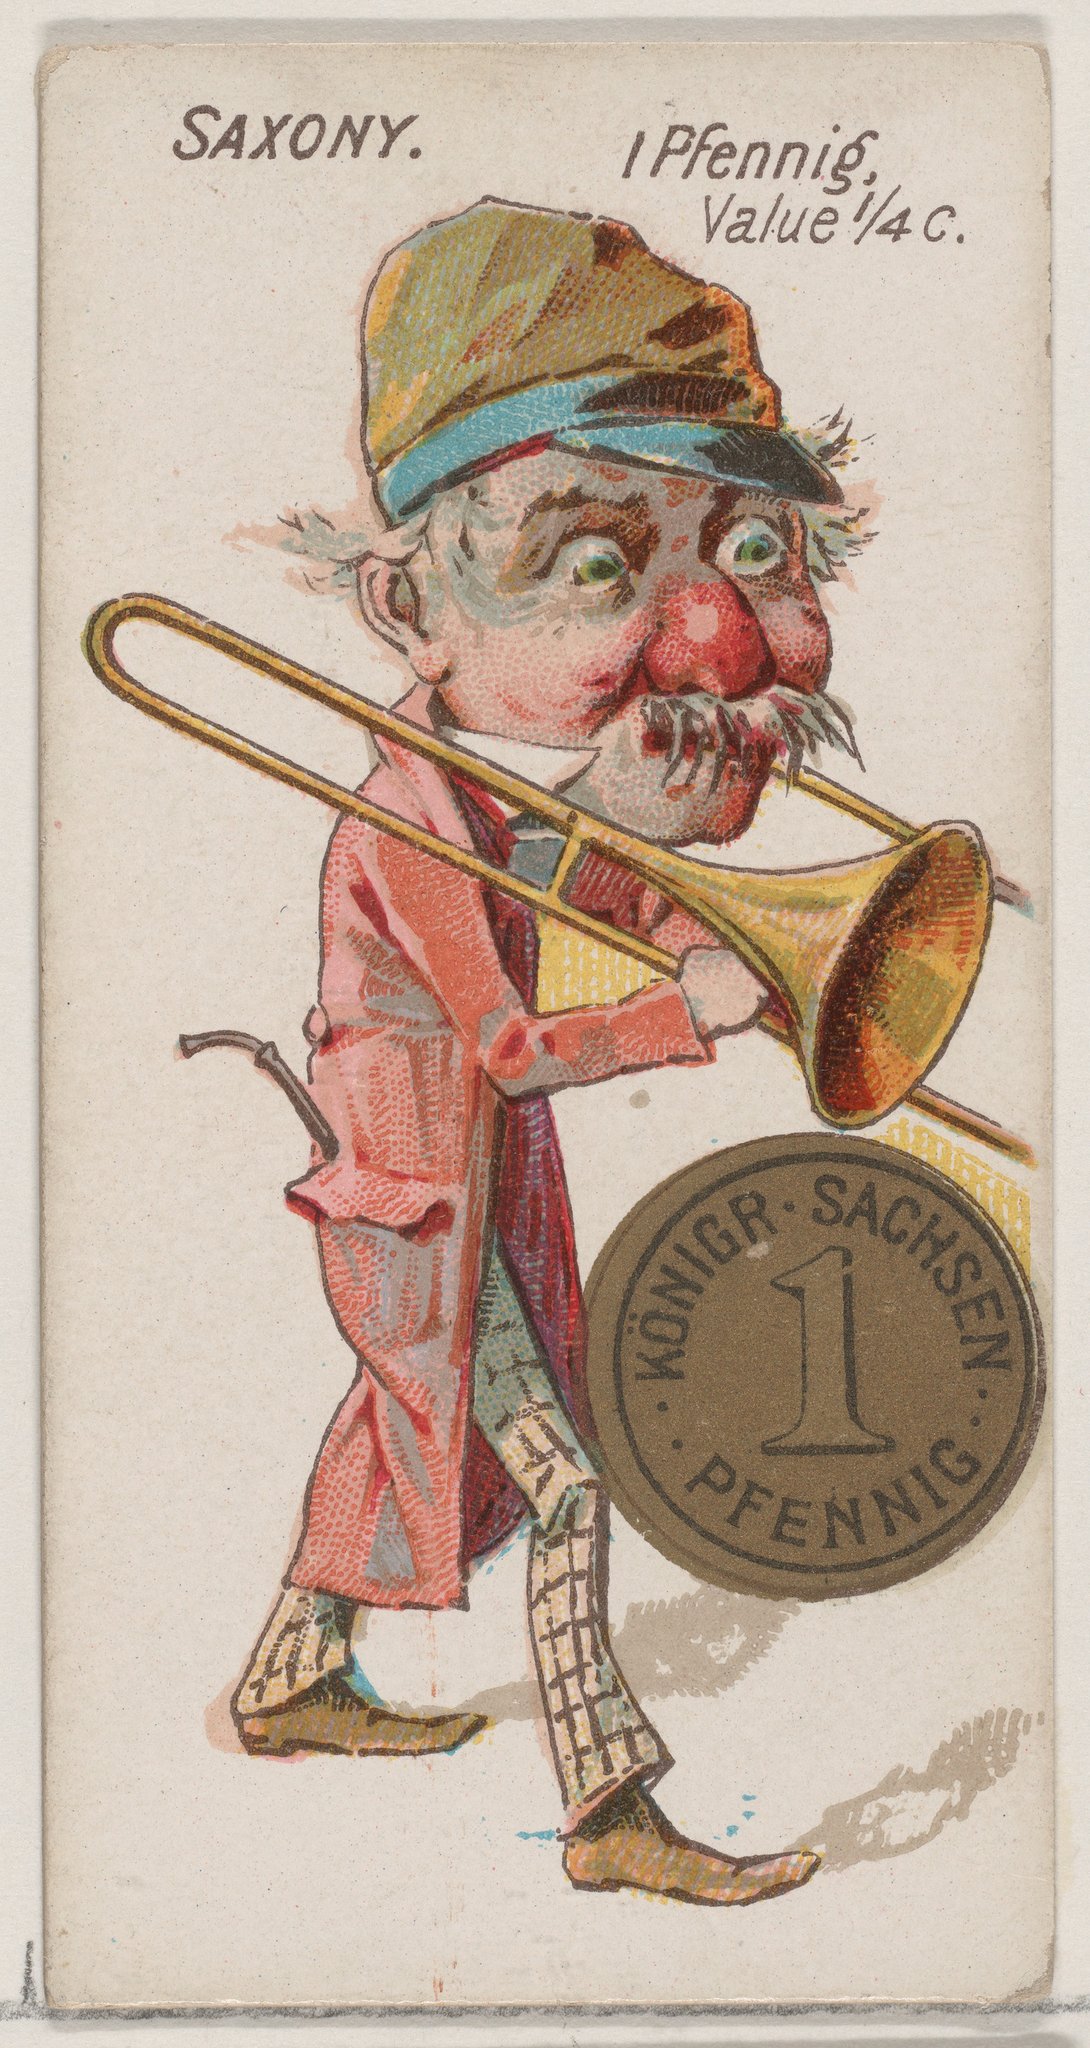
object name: print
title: Saxony, 1 Pfennig, from the series Coins of All Nations (N72, variation 1) for Duke brand cigarettes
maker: w. duke, sons & co.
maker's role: publisher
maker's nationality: american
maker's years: 1870-1920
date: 1889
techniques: color lithograph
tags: musical instruments,men,coins